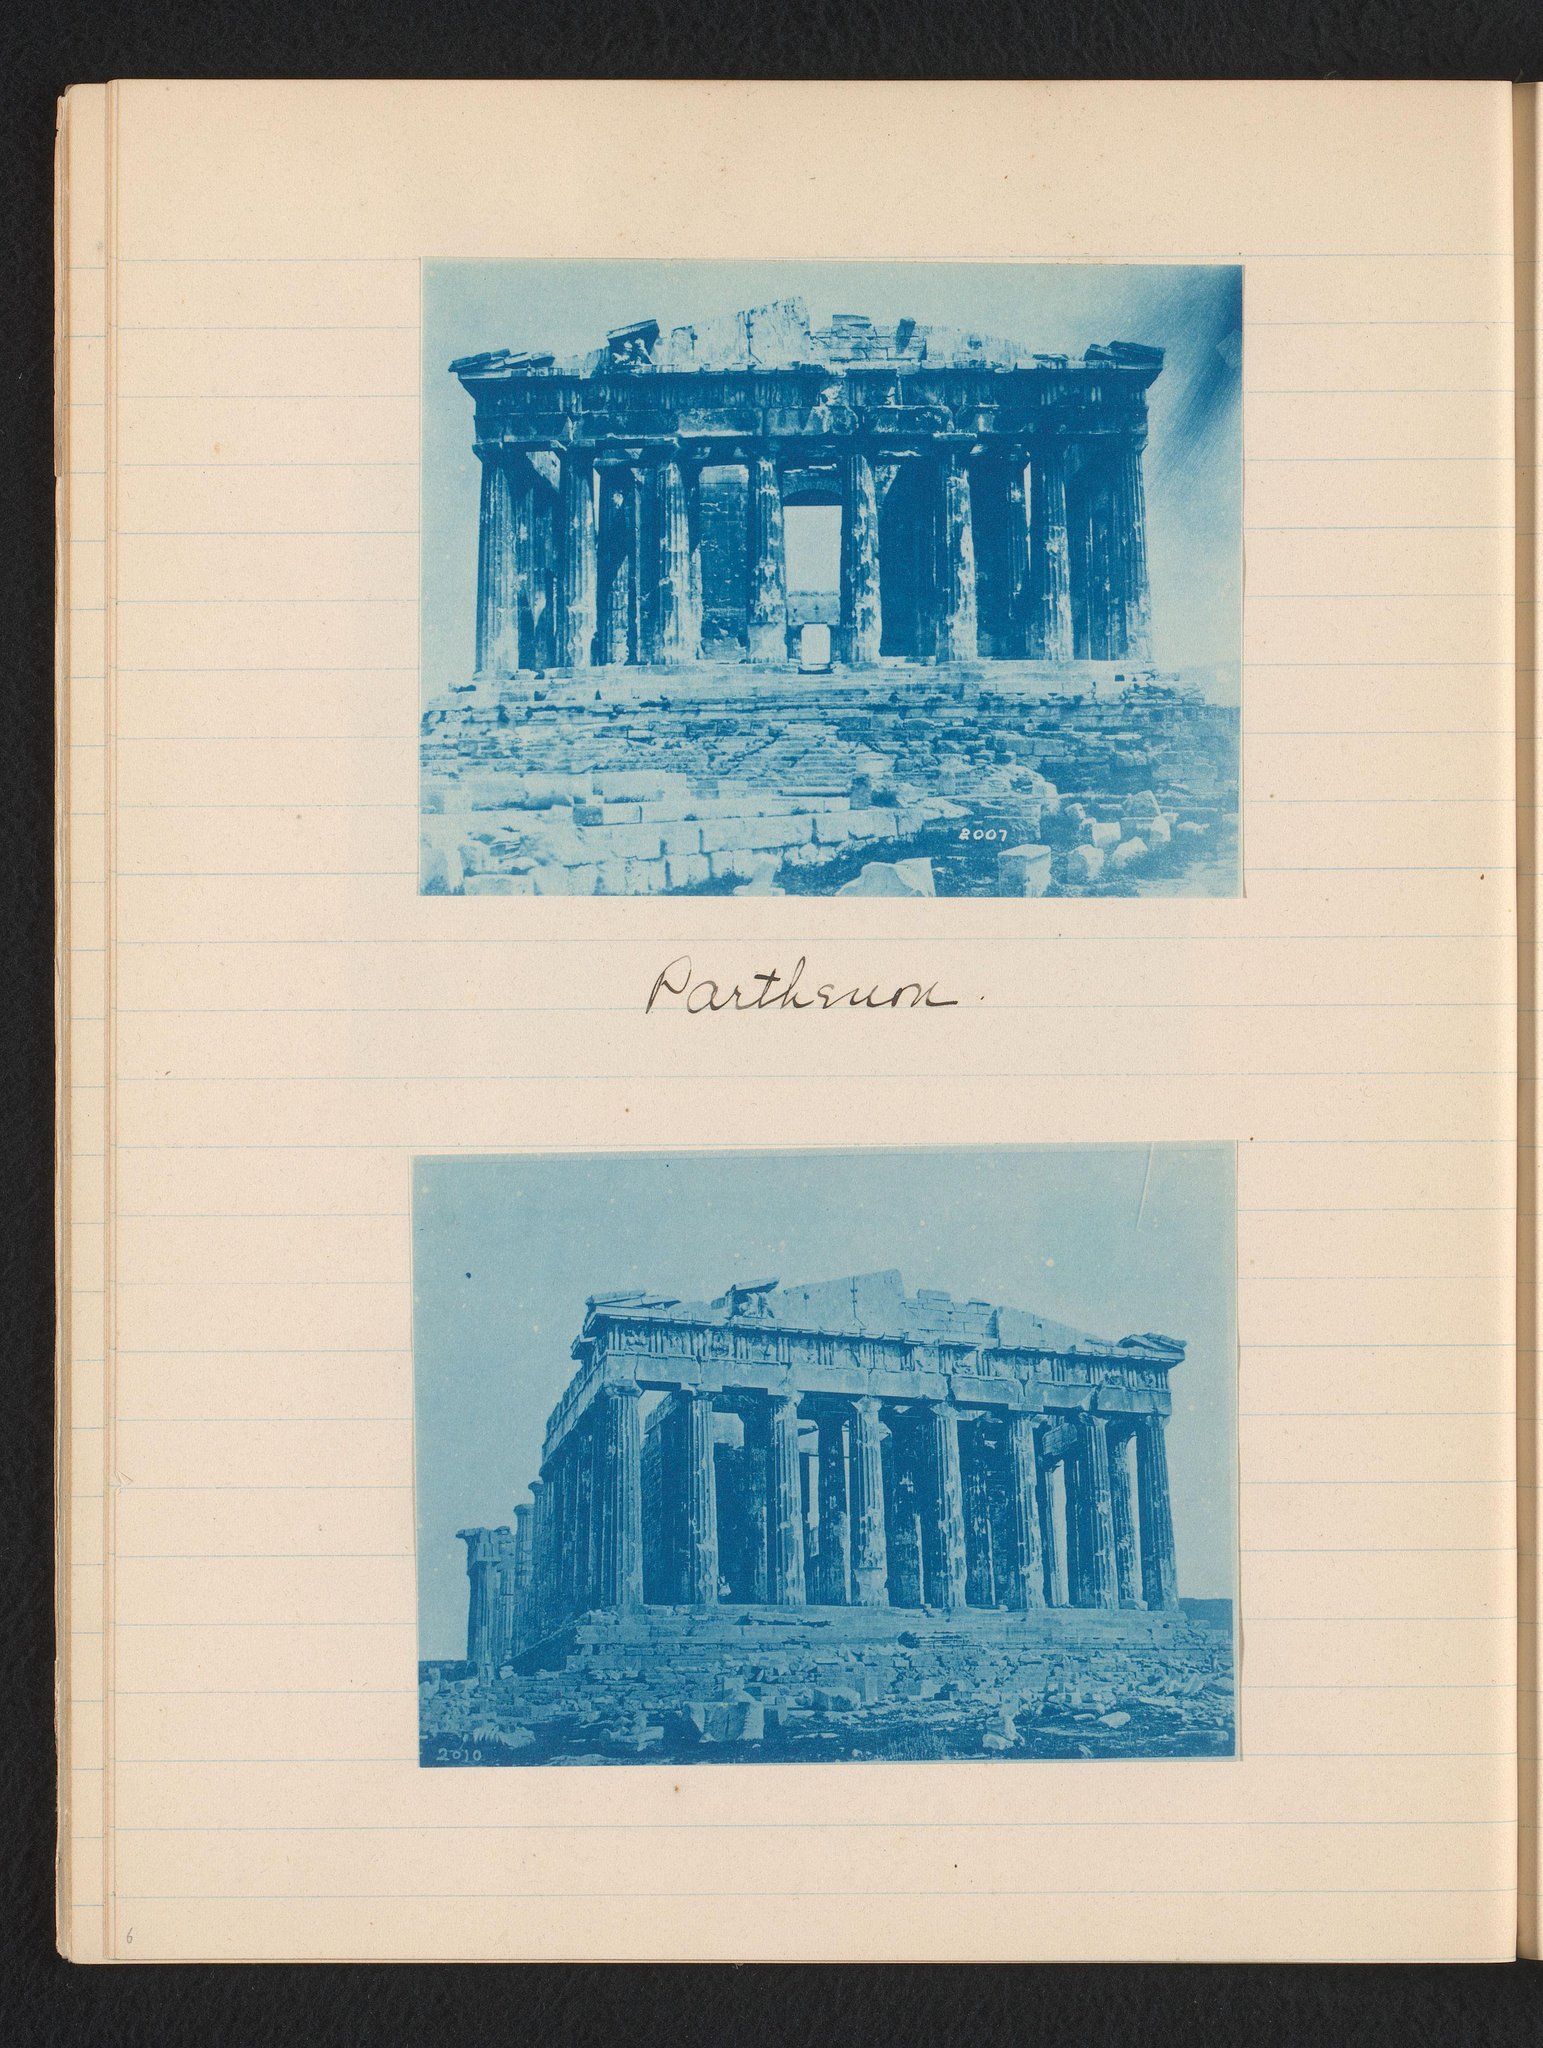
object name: photograph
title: Twee foto's van het Parthenon op de Akropolis van Athene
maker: Anonymous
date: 1901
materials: paper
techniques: cyanotype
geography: athens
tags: ruin of a building ~ architecture, temple, shrine ~ greek religion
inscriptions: inscription: ‘Parthenon’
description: Deze foto's maken deel uit van een album.